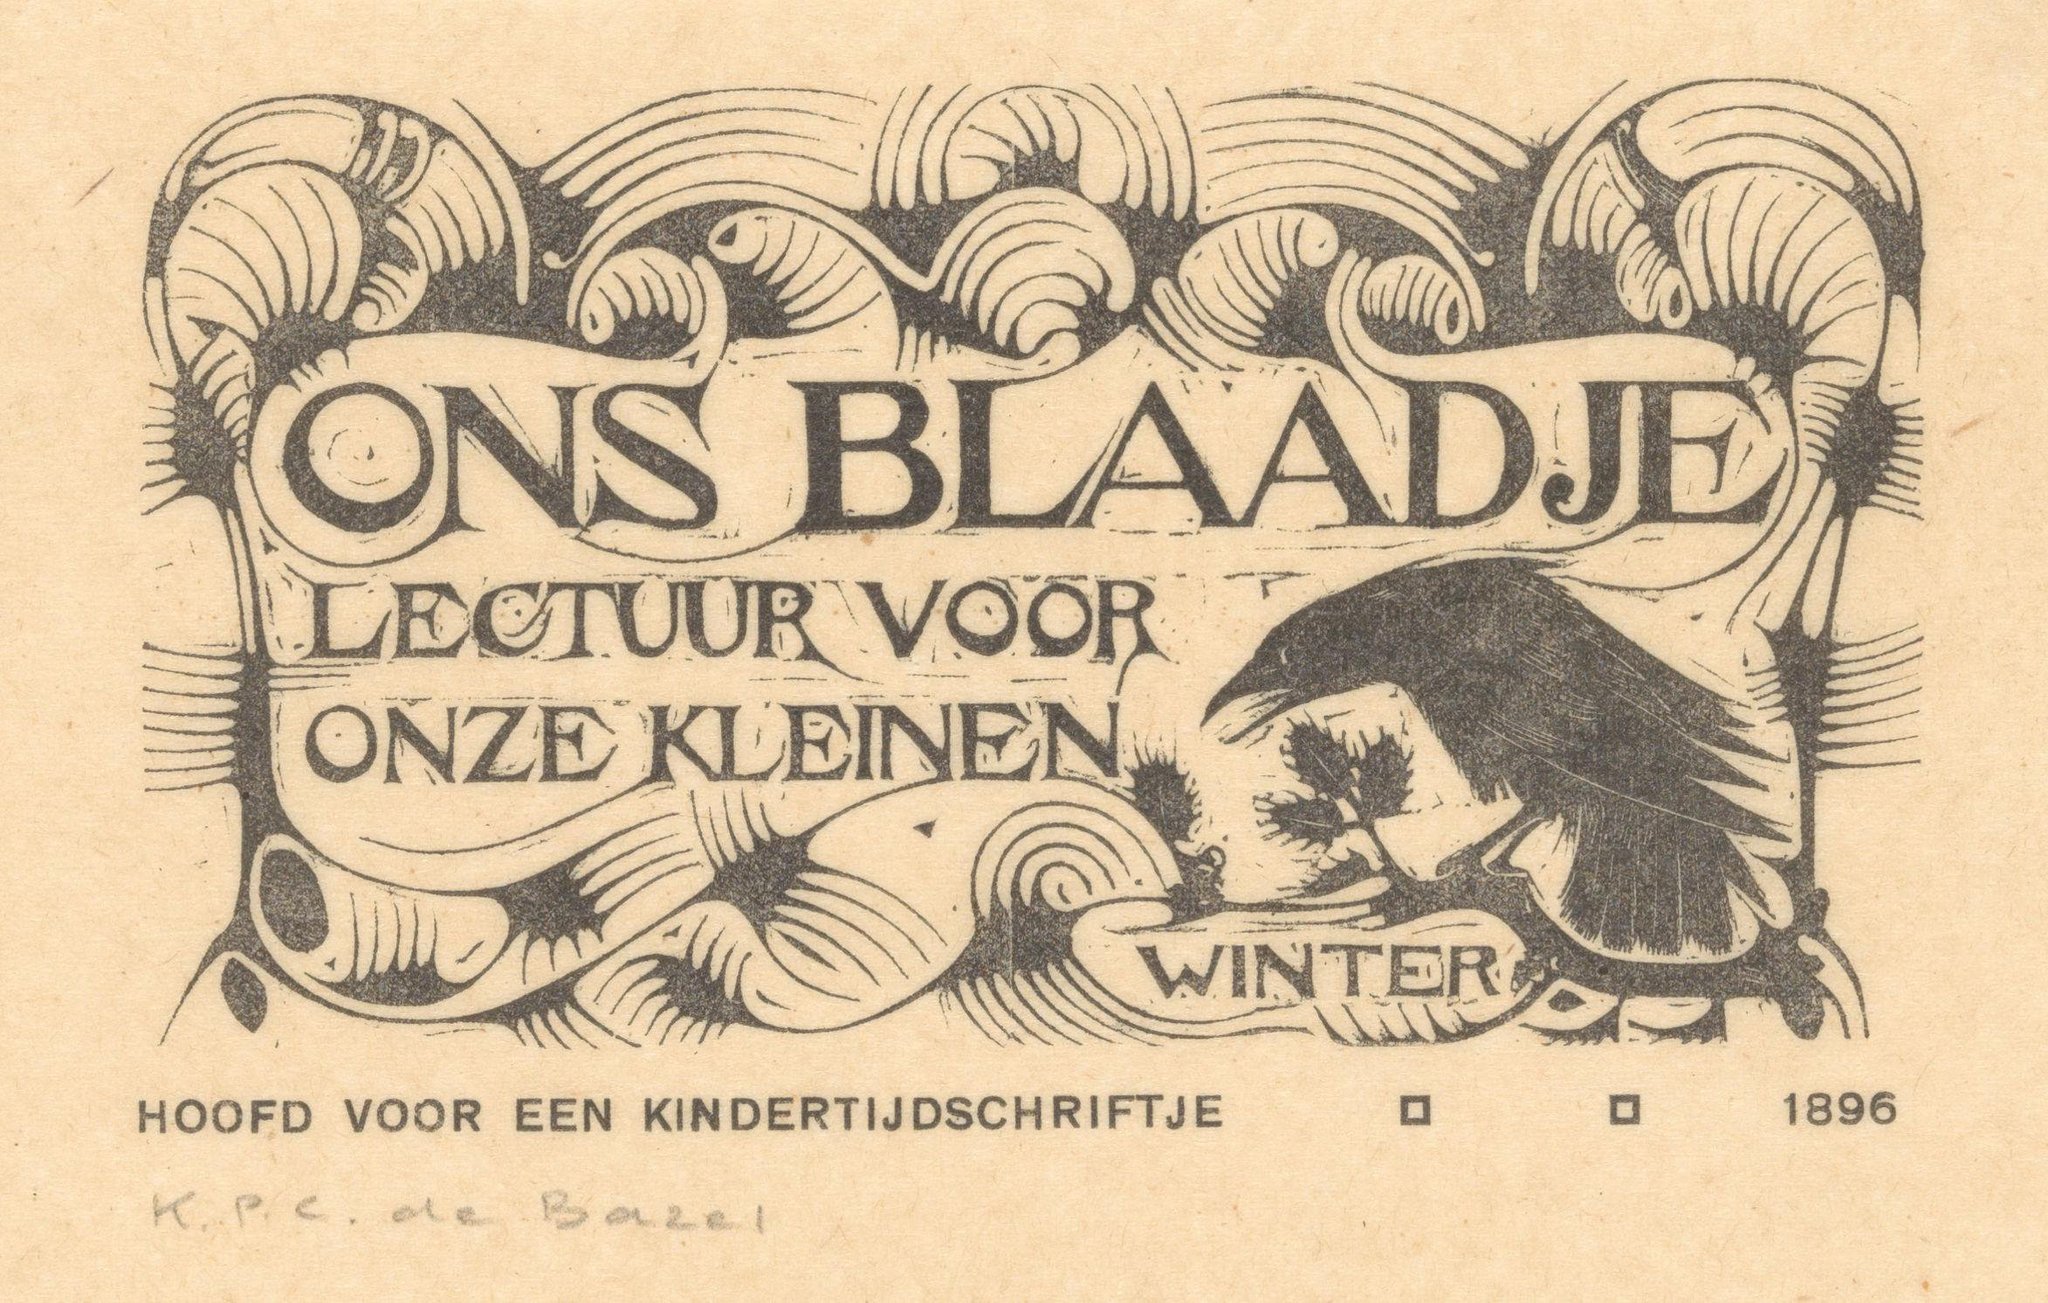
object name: print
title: Titelvignet voor Ons Blaadje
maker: karel petrus cornelis de bazel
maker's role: draughtsman, print maker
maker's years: 1869-1923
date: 1896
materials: paper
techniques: woodcut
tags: song-birds: crow, persons ~ printing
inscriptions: annotation: ‘hoofd voor een kindertijdschriftje, 1896’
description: Prent afkomstig uit: Wendingen. Amsterdam: De Hooge Brug, 1919. Jaargang 2, nummer 7-8. De huidige titel is door het museum toegekend bij gebrek aan informatie over een originele titel.